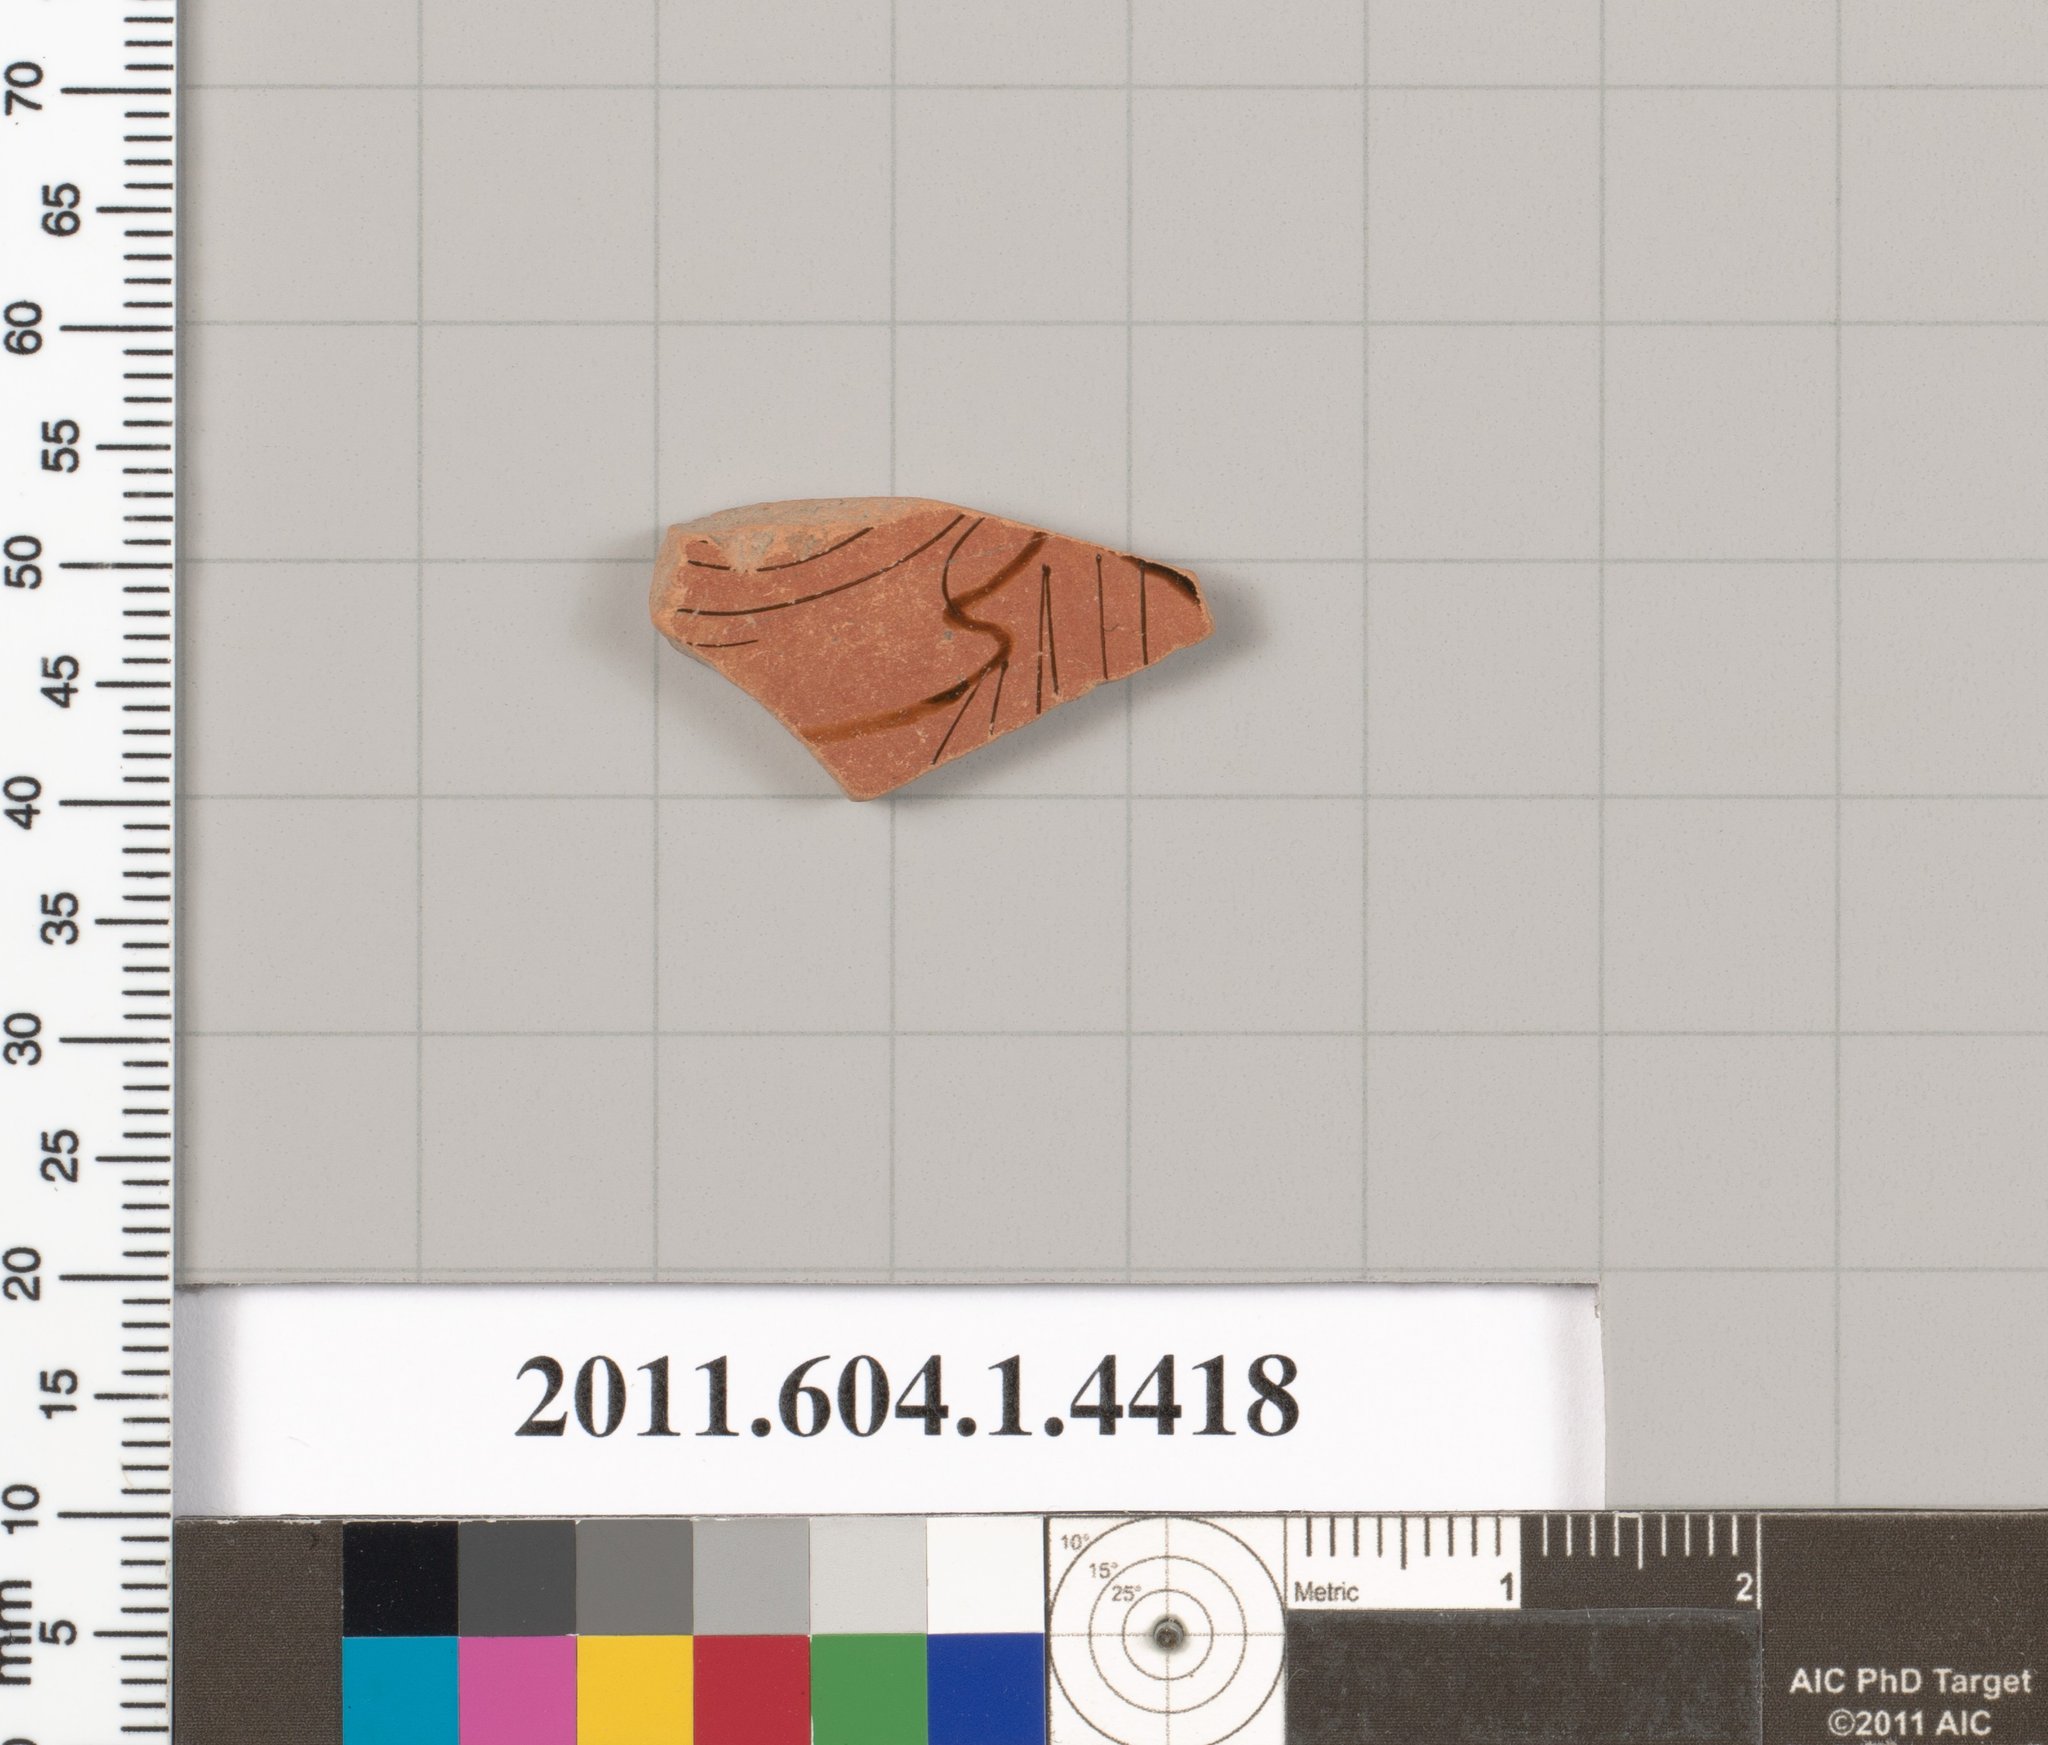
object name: kylix fragment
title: Terracotta fragment of a kylix (drinking cup)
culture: greek, attic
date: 475-451 BCE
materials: terracotta